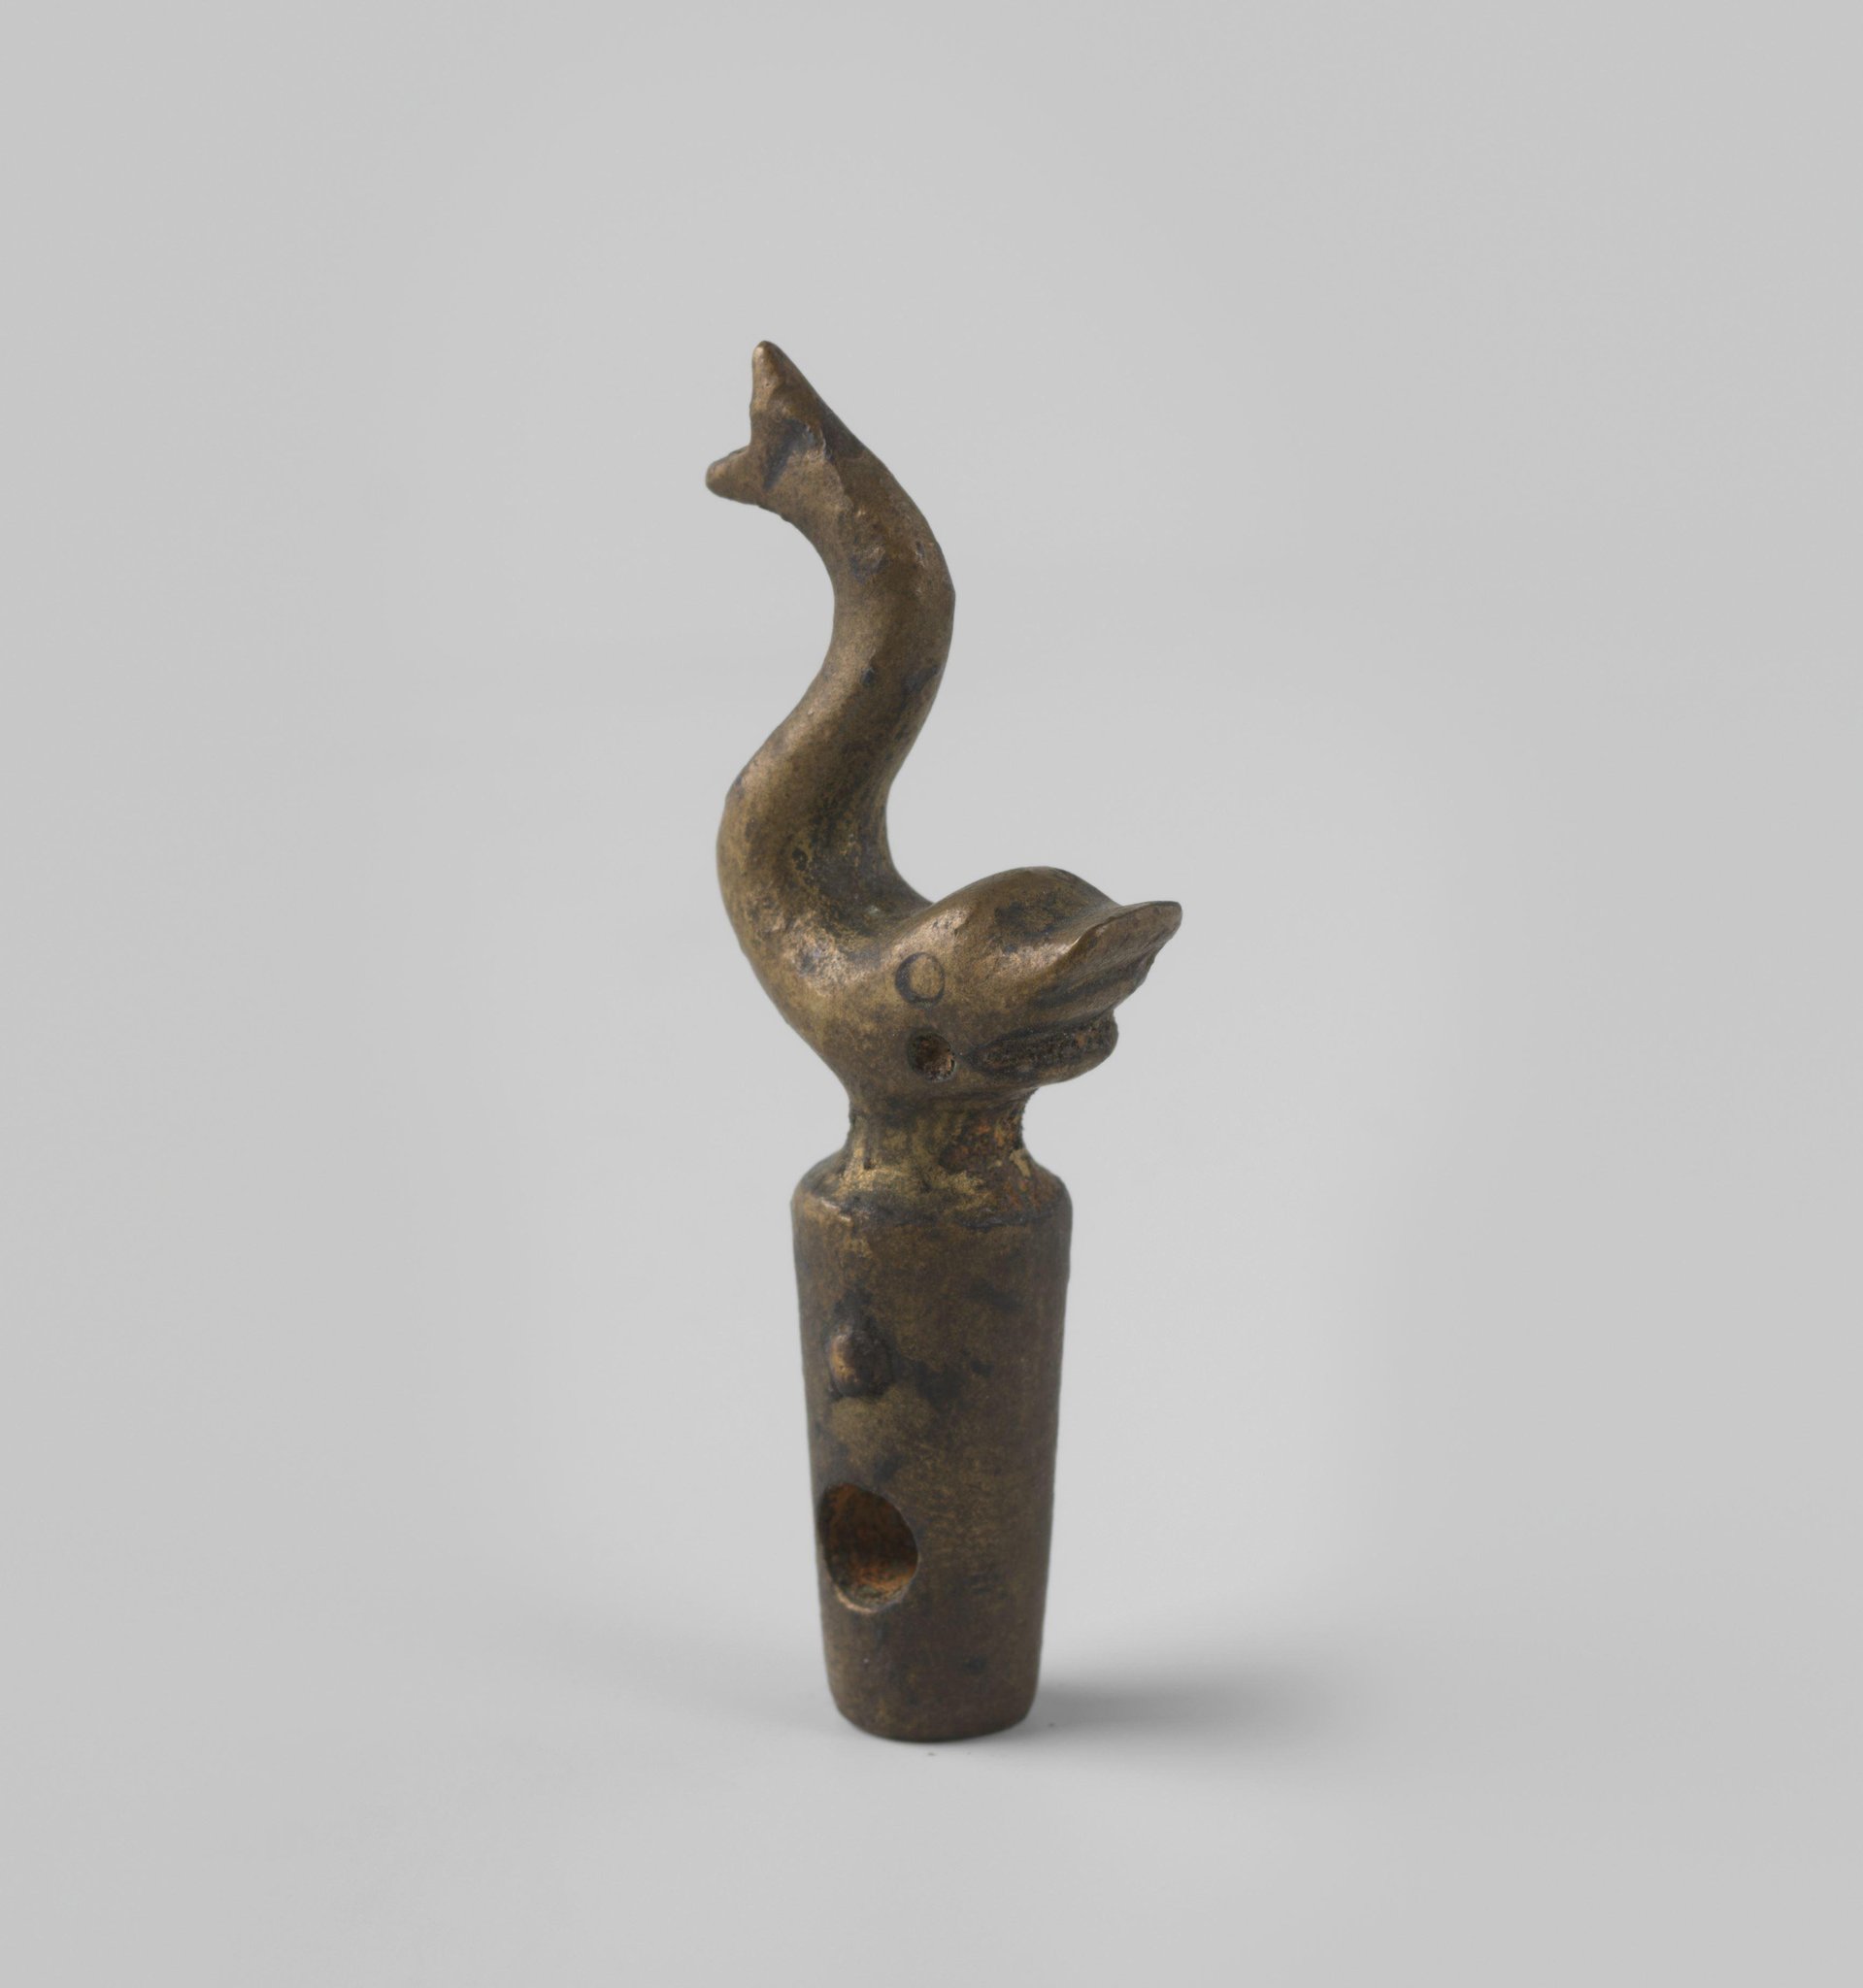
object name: tap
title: Onderdeel van een kraan uit het wrak van de Oost-Indiëvaarder Meresteijn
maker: Anonymous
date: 1693-1702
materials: brass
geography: netherlands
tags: cape of good hope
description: Kraan bestaande uit massieve taps toelopende tap met dwars een (doorlaat)gat. De bedienigshendel is in de vorm van een vis die met zijn staart slaat. Tap.